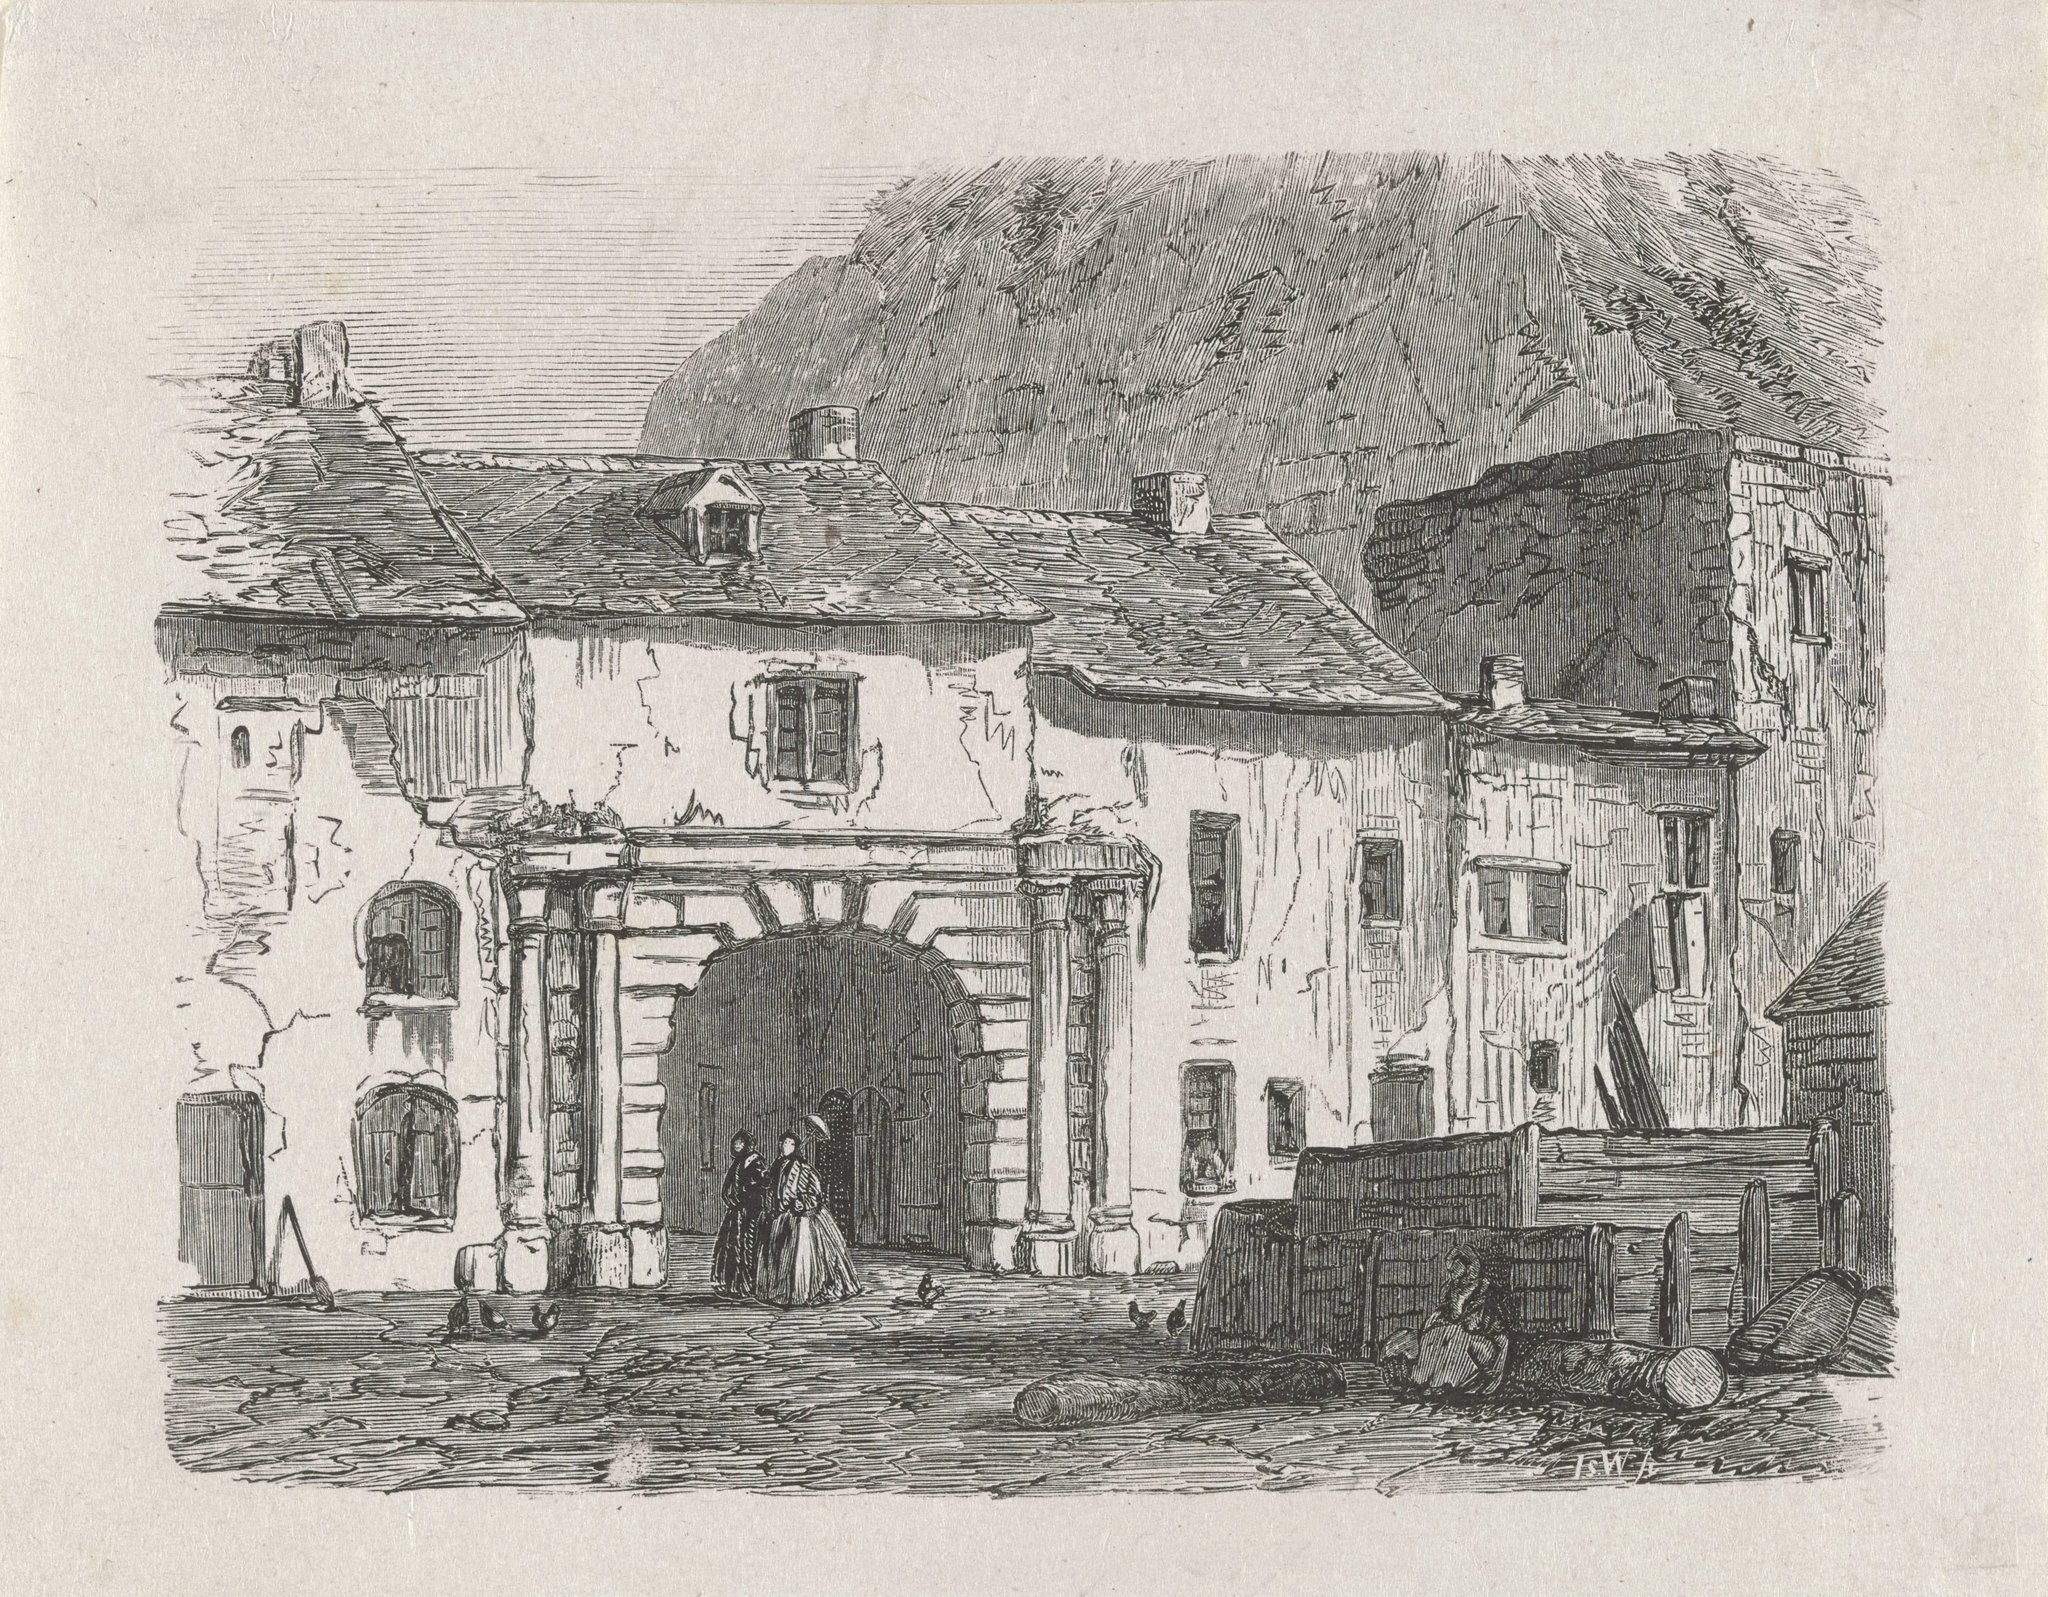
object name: print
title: Poort in de voorstad Claussen van de stad Luxemburg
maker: isaac weissenbruch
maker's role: print maker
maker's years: 1826-1912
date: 1836-1912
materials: paper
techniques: engraving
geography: netherlands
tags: gate, entrance, street (+ city(-scape) with figures, staffage), mountains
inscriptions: collector's mark: Lugt 2228